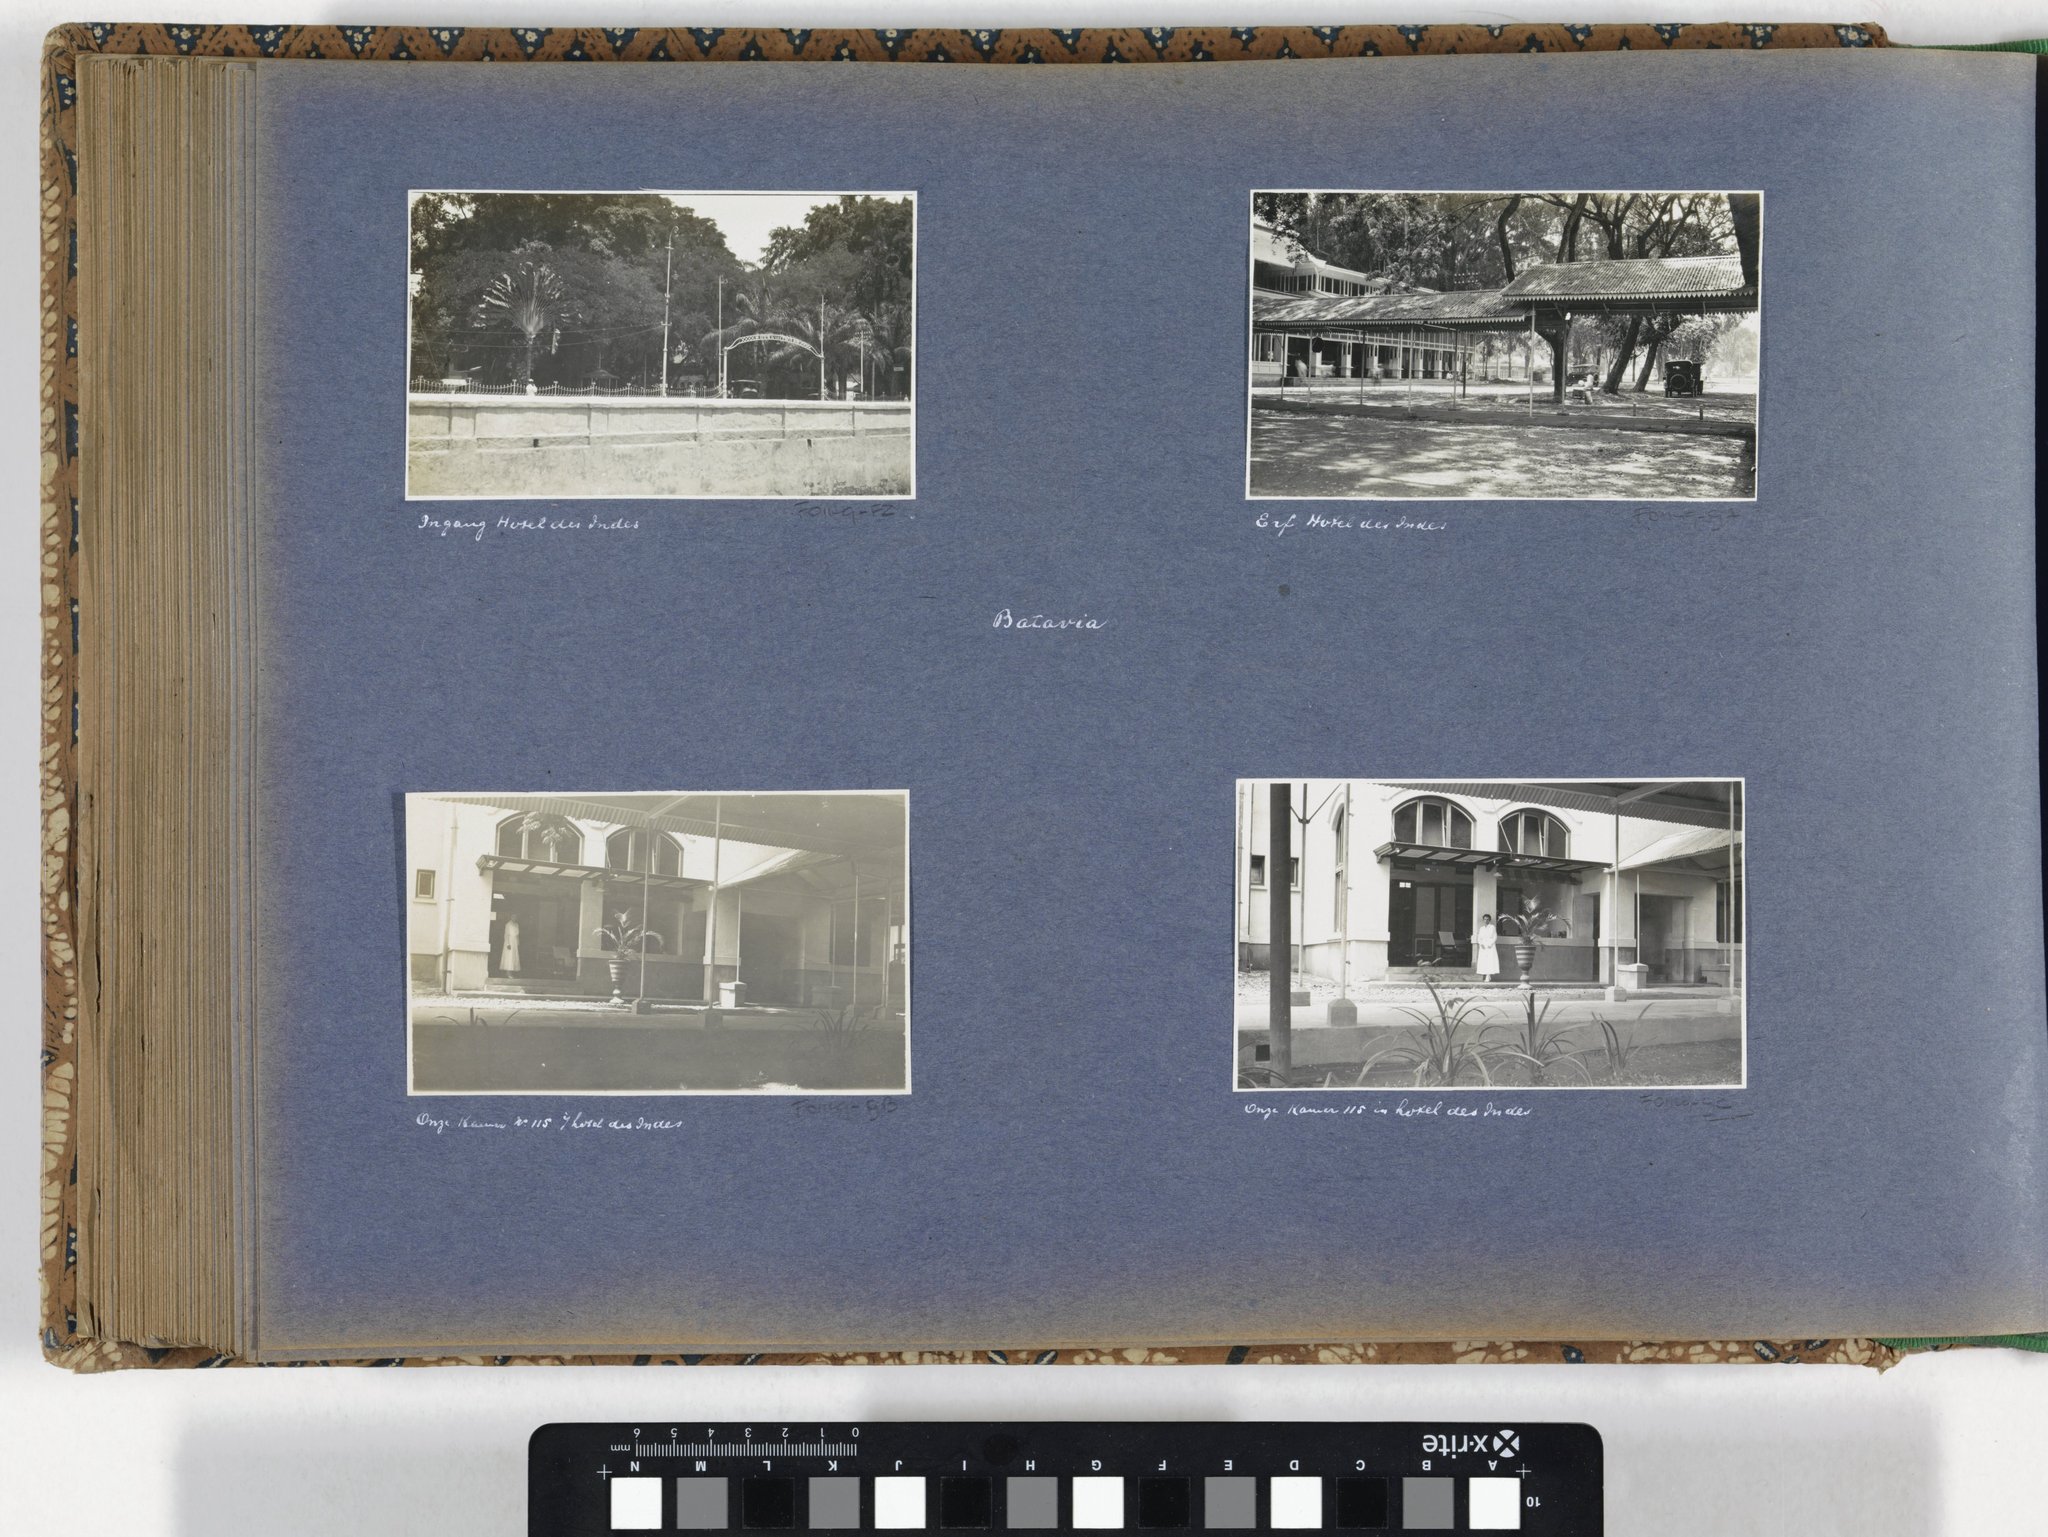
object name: photograph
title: Ingang van Hotel des Indes in Batavia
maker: Anonymous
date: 1900-1920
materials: paper, photographic support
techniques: gelatin silver print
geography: batavia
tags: gate, entrance, hotel, hostelry, inn, batavia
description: Onderdeel van reisalbum met foto's van bedrijvigheid en bezienswaardigheden op Sumatra en Java en van de reis naar en van Nederlands-Indië.